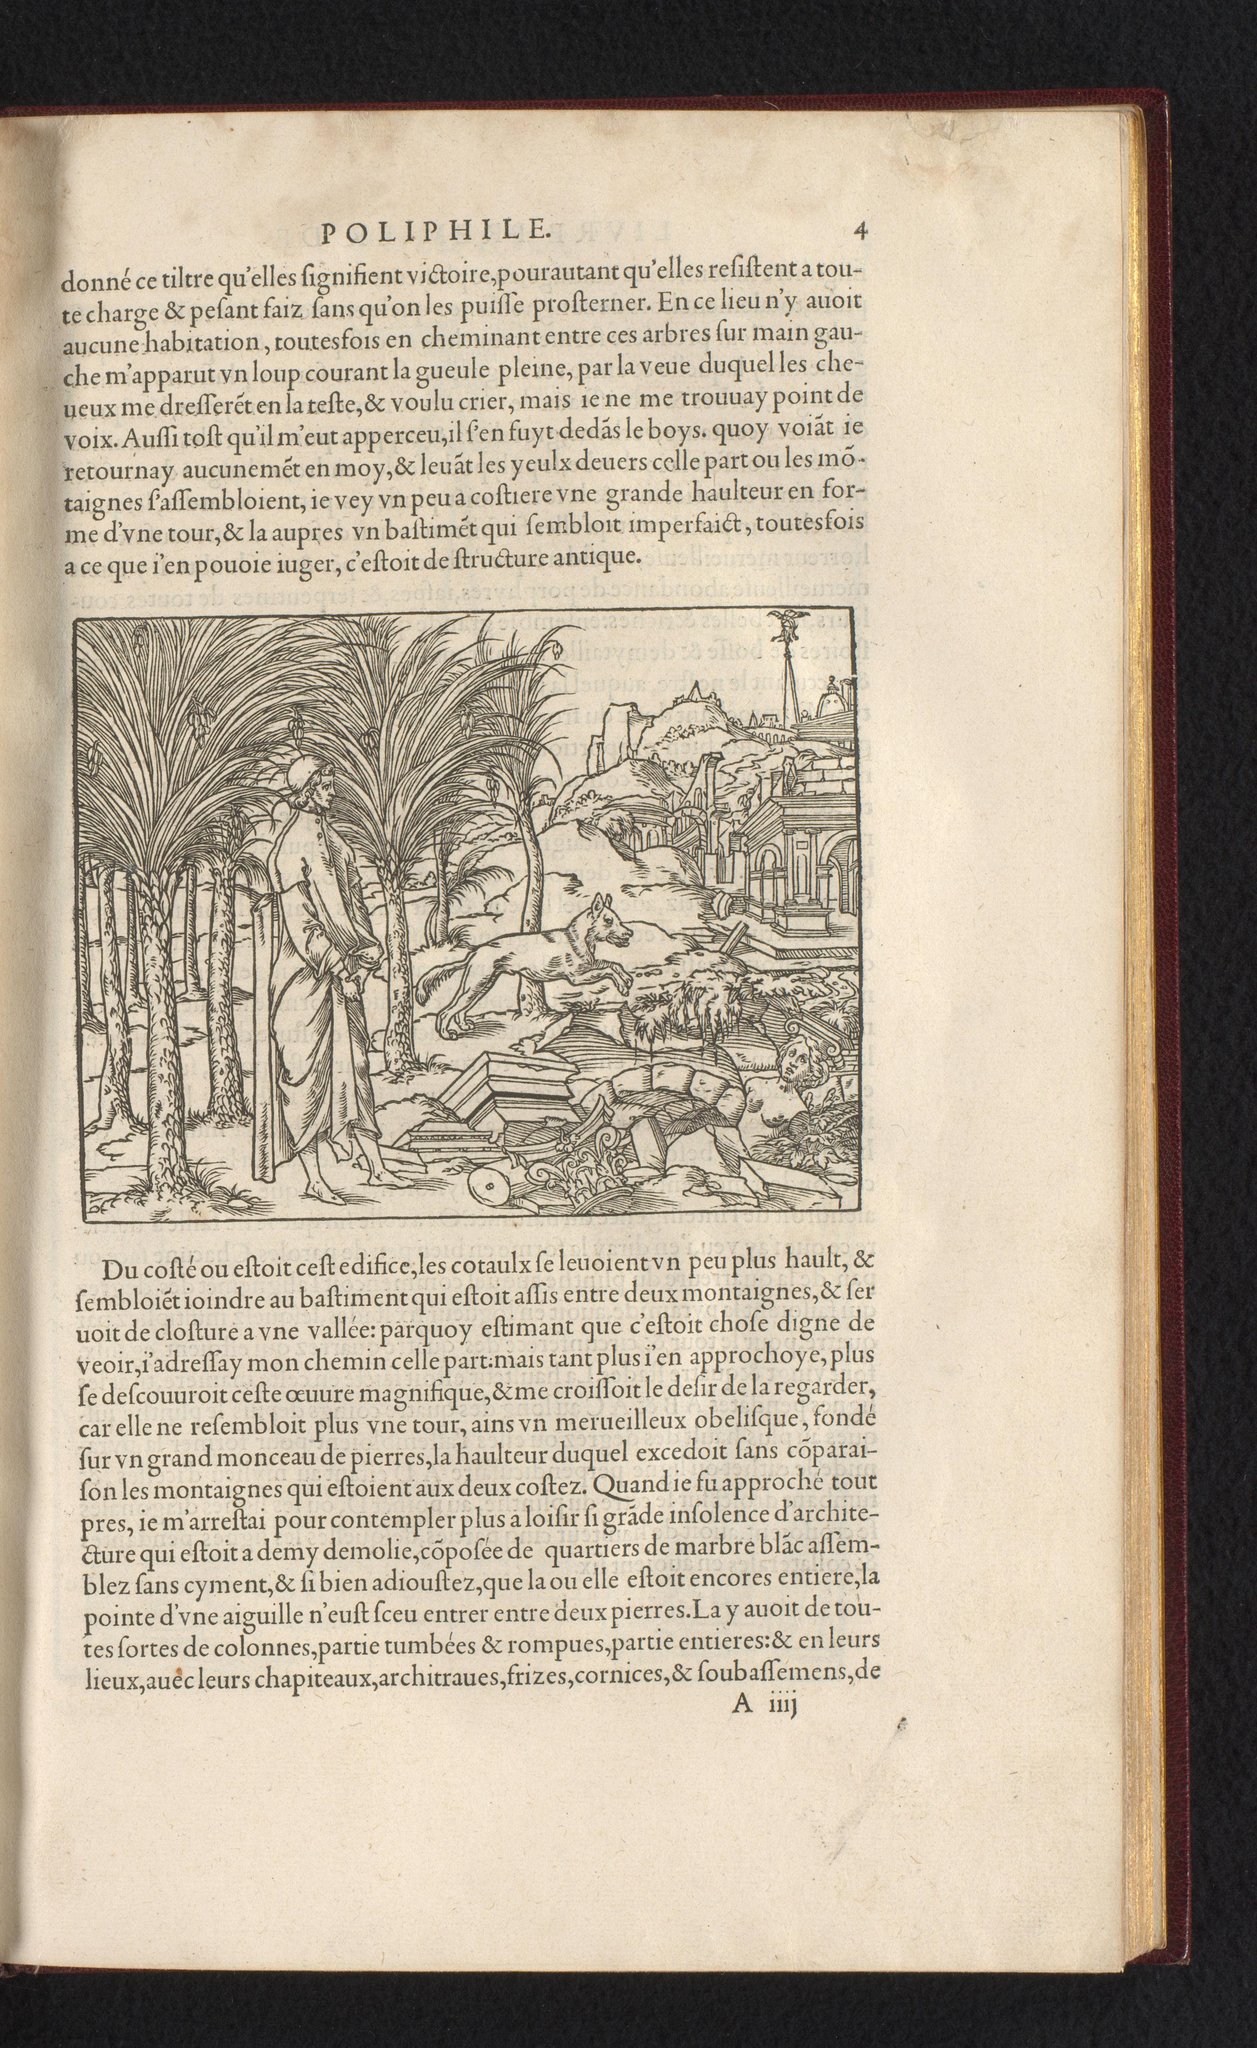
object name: print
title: Poliphilo volgt een wolf naar de ruïnes van een stad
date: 1546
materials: paper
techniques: letterpress printing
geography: paris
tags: (scenes from) specific works of literature: colonna, hypnerotomachia poliphili, landscape with ruins, ruin of a dwelling, house, castle, etc., beasts of prey, predatory animals: wolf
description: Prent uit: Colonna, Francesco. Hypnerotomachie ou discours du songe de Poliphile, deduisant comme amour le combat a l'occasion de Polia. Parijs: Jacques Kerver, 1546, recto fol. 4.